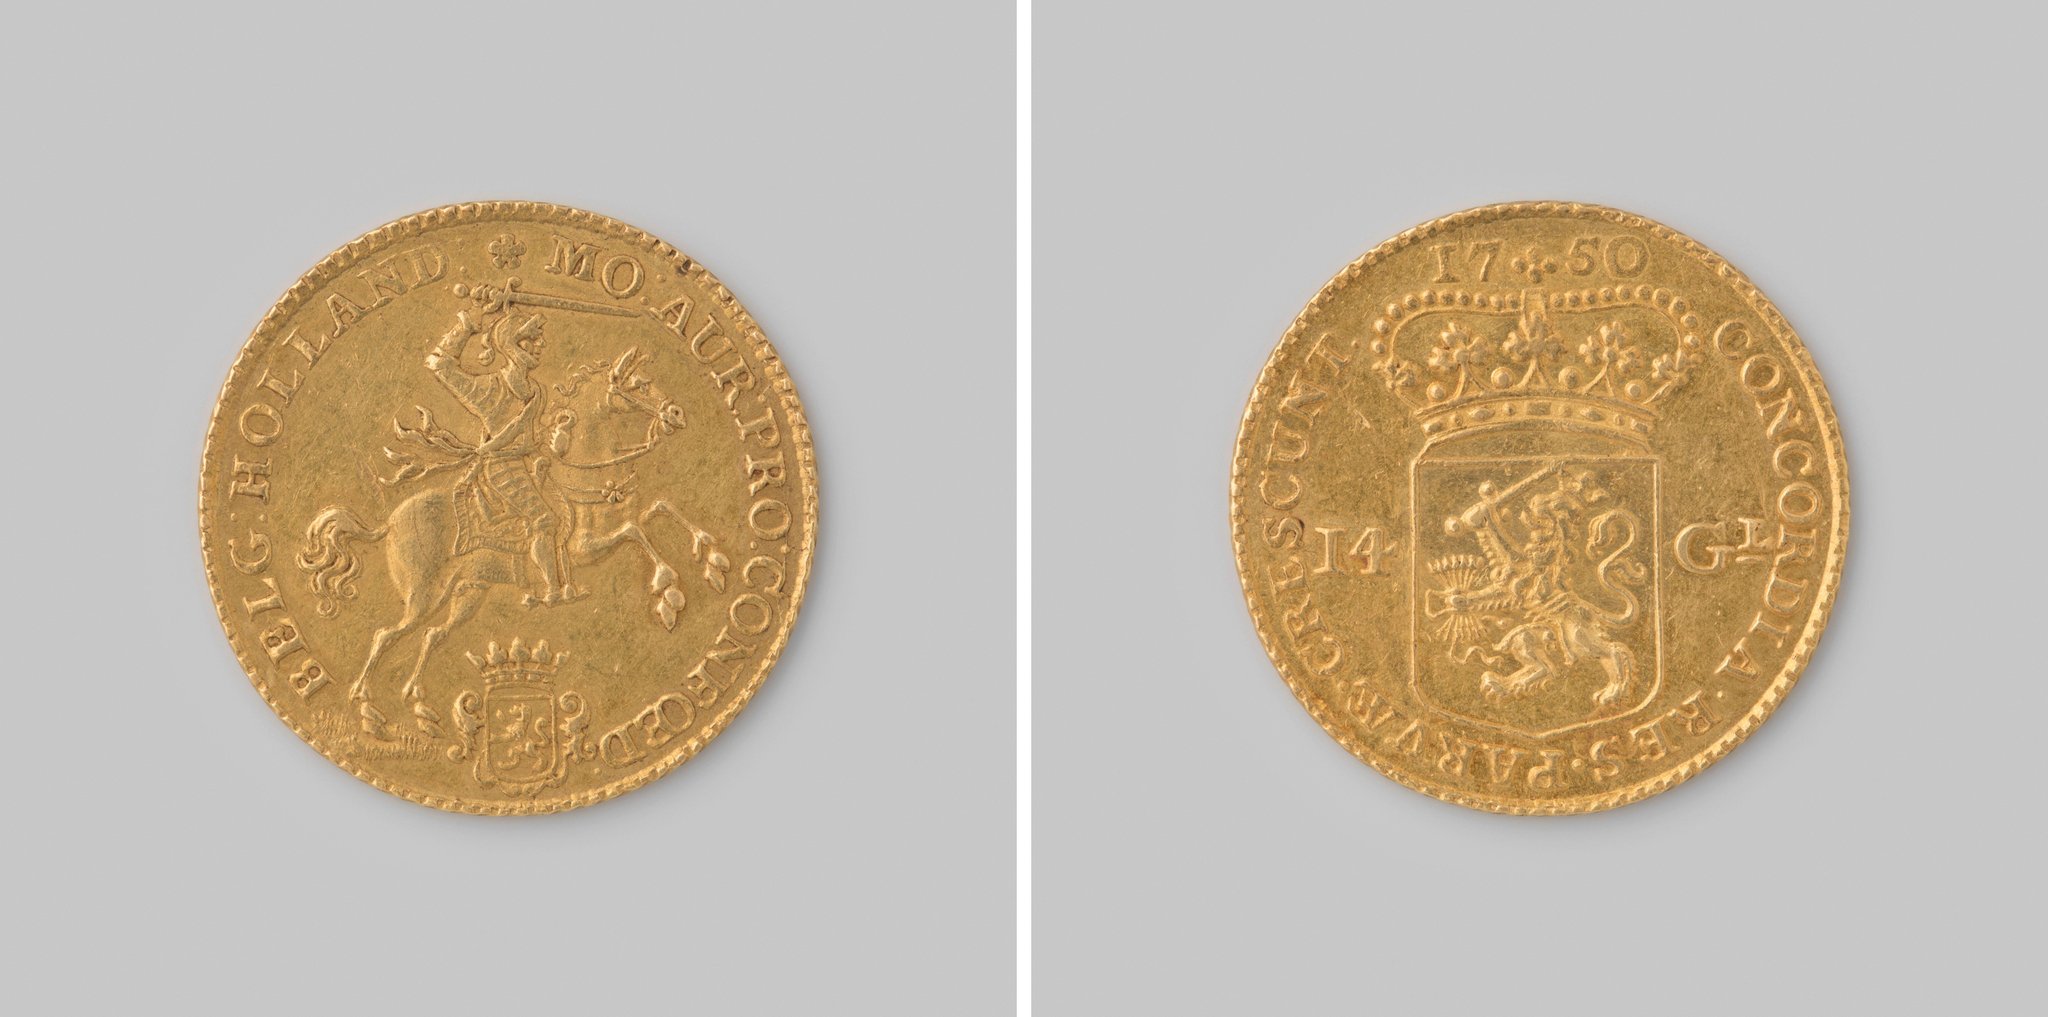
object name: gouden rijder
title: Hollandse gouden rijder, 1750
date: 1750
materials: gold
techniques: striking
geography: dordrecht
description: Gouden munt. Voorzijde: ridder te paard met in rechterhand zwaard naar rechts, waaronder versierd gekroond wapenschild van Holland. Keerzijde: tussen waarde-aanduiding gekroond generaliteitswapenschild. Boven kroon jaartal. Kabelrand.